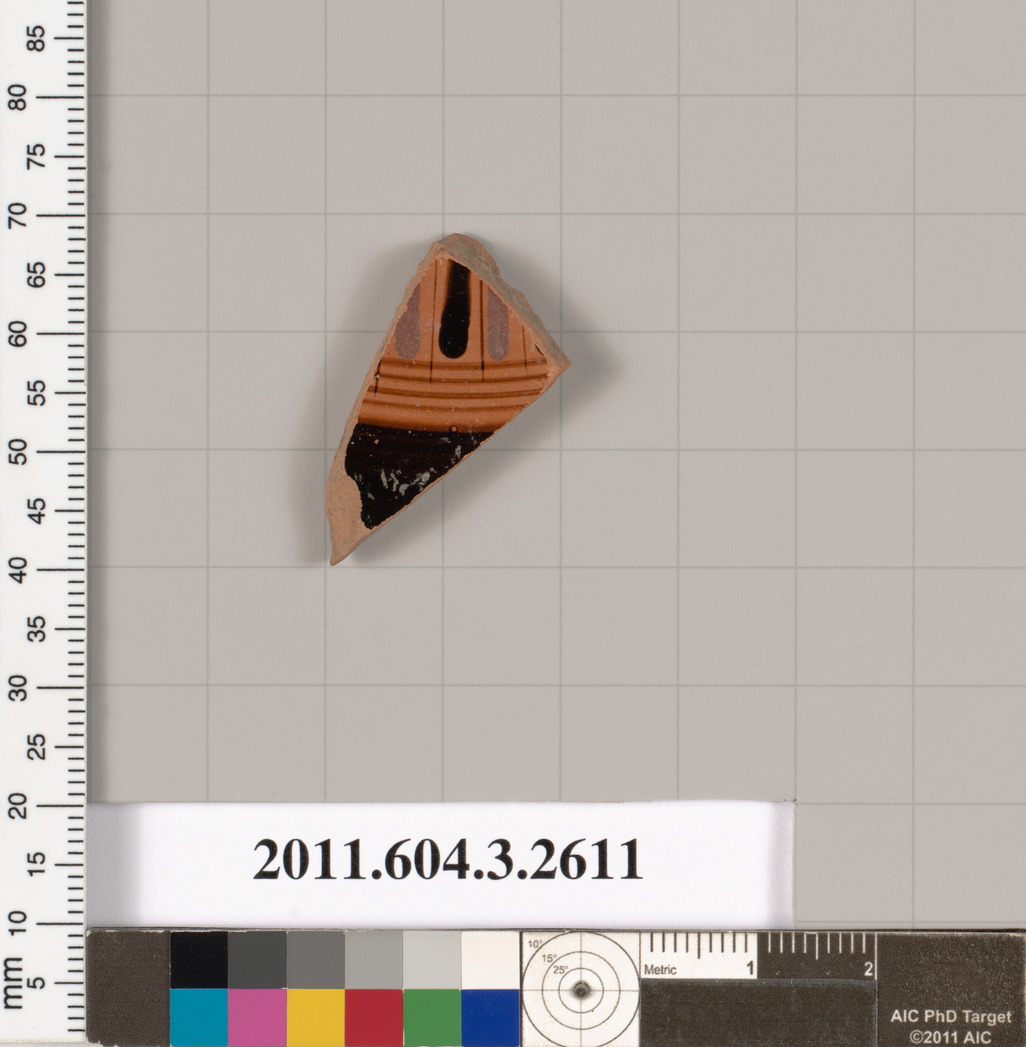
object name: kylix fragment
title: Terracotta fragment of a Little Master cup (drinking cup) ?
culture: greek, attic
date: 575-551 BCE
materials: terracotta